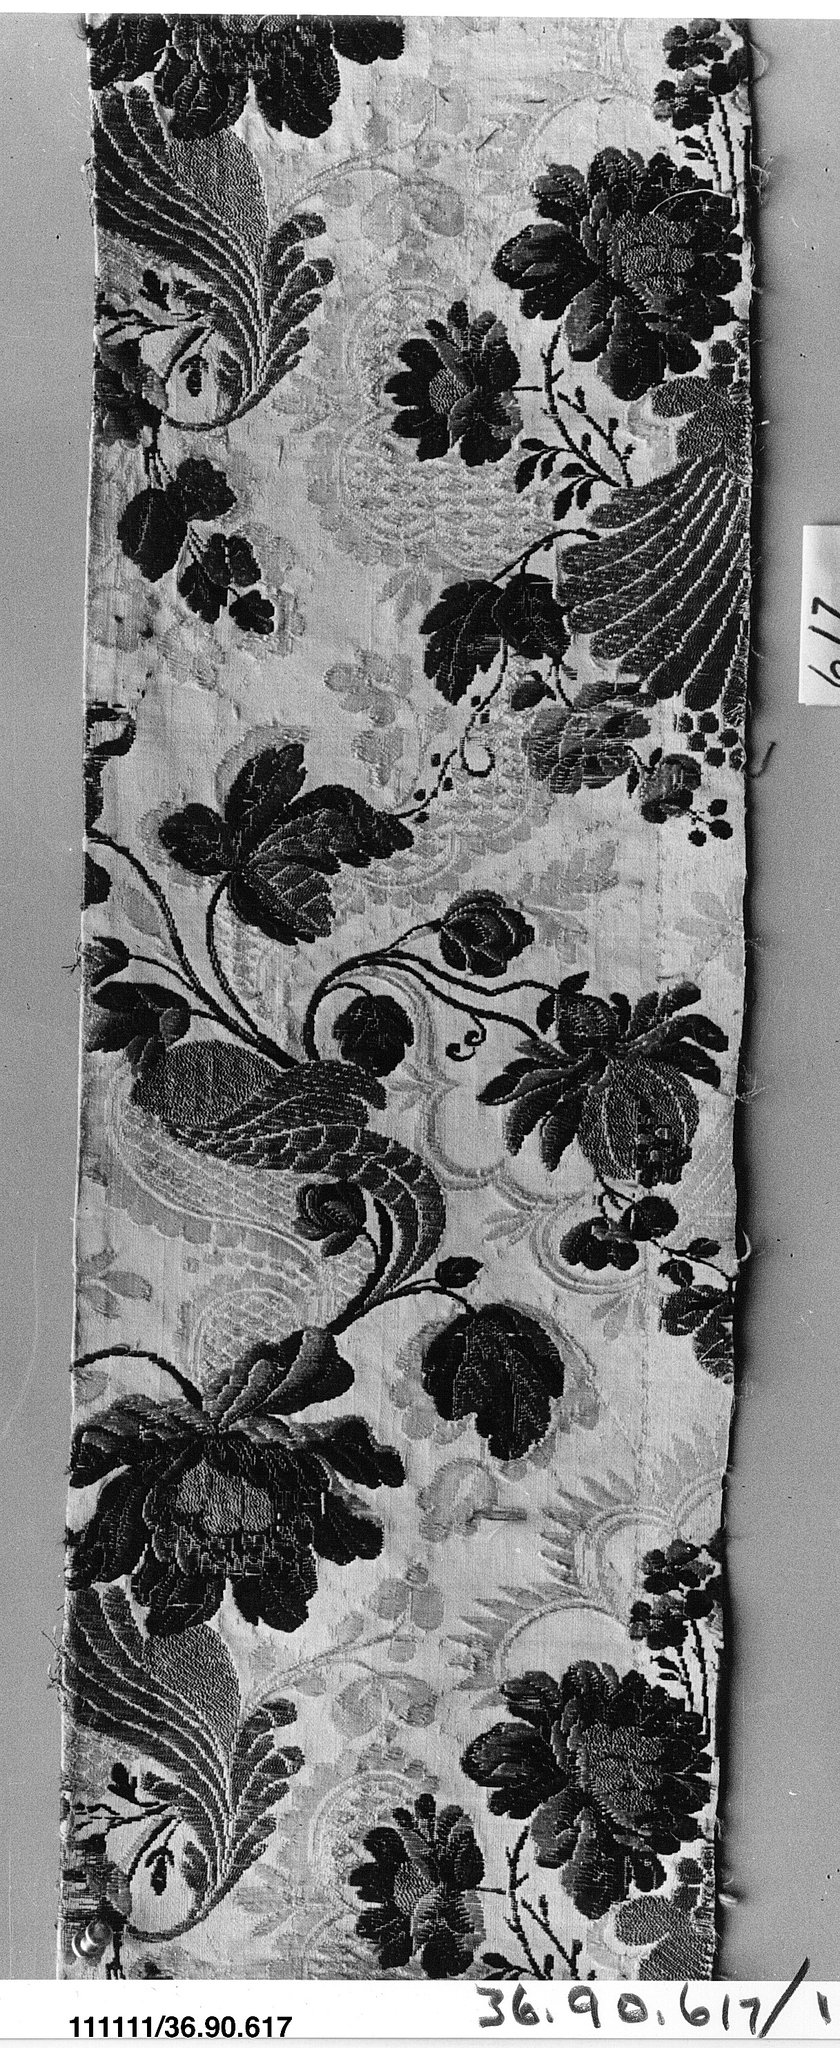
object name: piece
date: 1734-1766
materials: metal thread, silk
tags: flowers,leaves